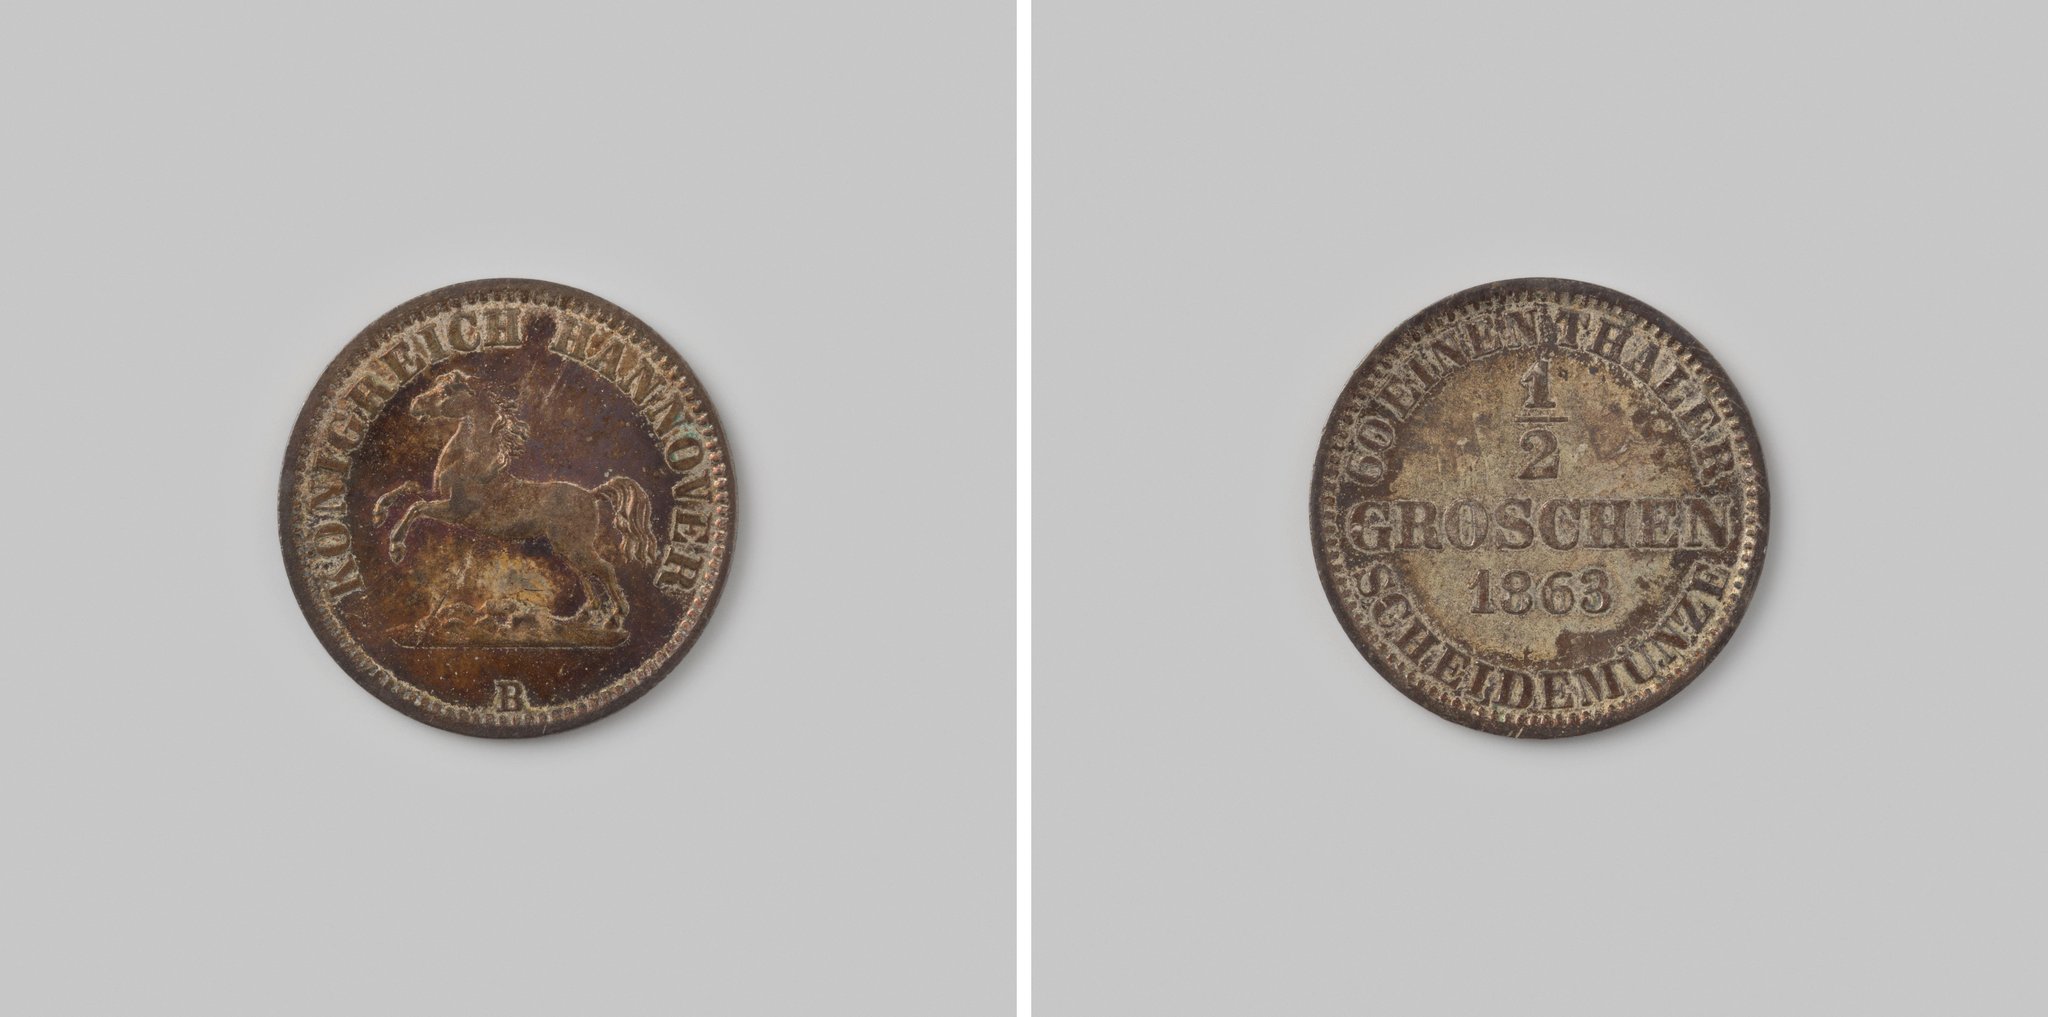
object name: coin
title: ½ groschen uit het koninkrijk Hannover van Georg V, 1863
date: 1863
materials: silver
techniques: striking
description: Zilveren munt. Voorzijde: op grond springend paard naar links. Daaronder letter S. Keerzijde: waarde-aanduiding in twee regels, waaronder jaartal. Kartelrand.